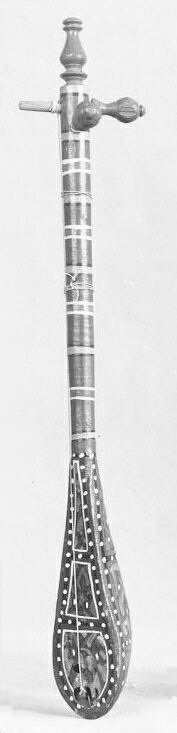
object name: guenbri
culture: egyptian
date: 1867-1900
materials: parchment, wood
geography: egypt